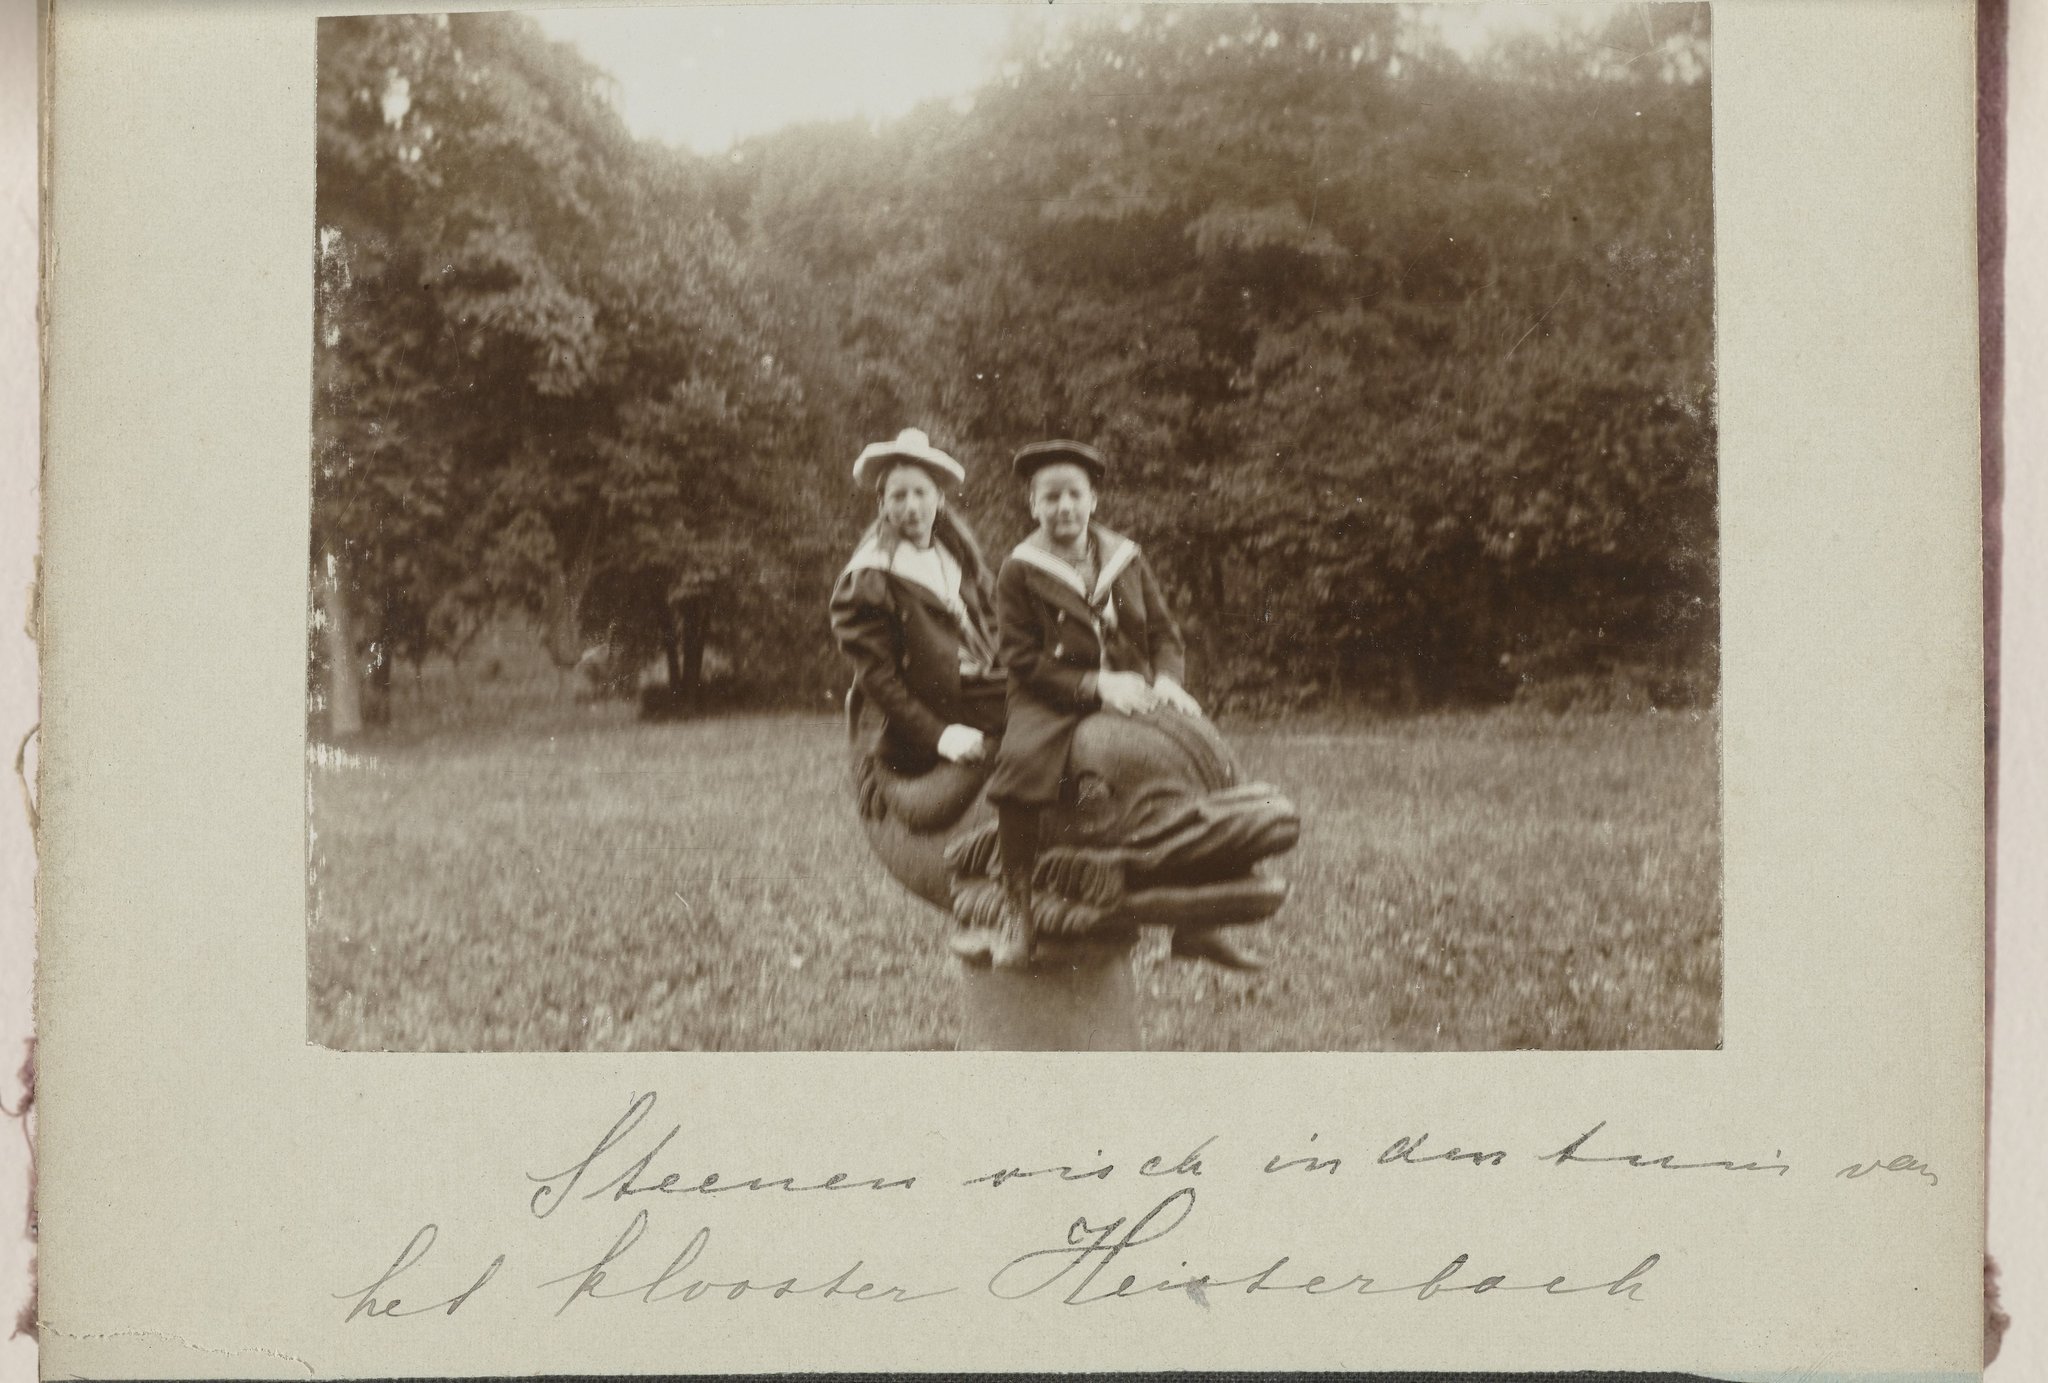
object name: album leaf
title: Steenen visch in den tuin van het klooster Heisterbach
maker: david vermeulen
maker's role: fotograaf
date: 1895-1905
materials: paper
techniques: collodion silver print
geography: heisterbach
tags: piece of sculpture, reproduction of a piece of sculpture, child between toddler and youth (of undetermined sex)